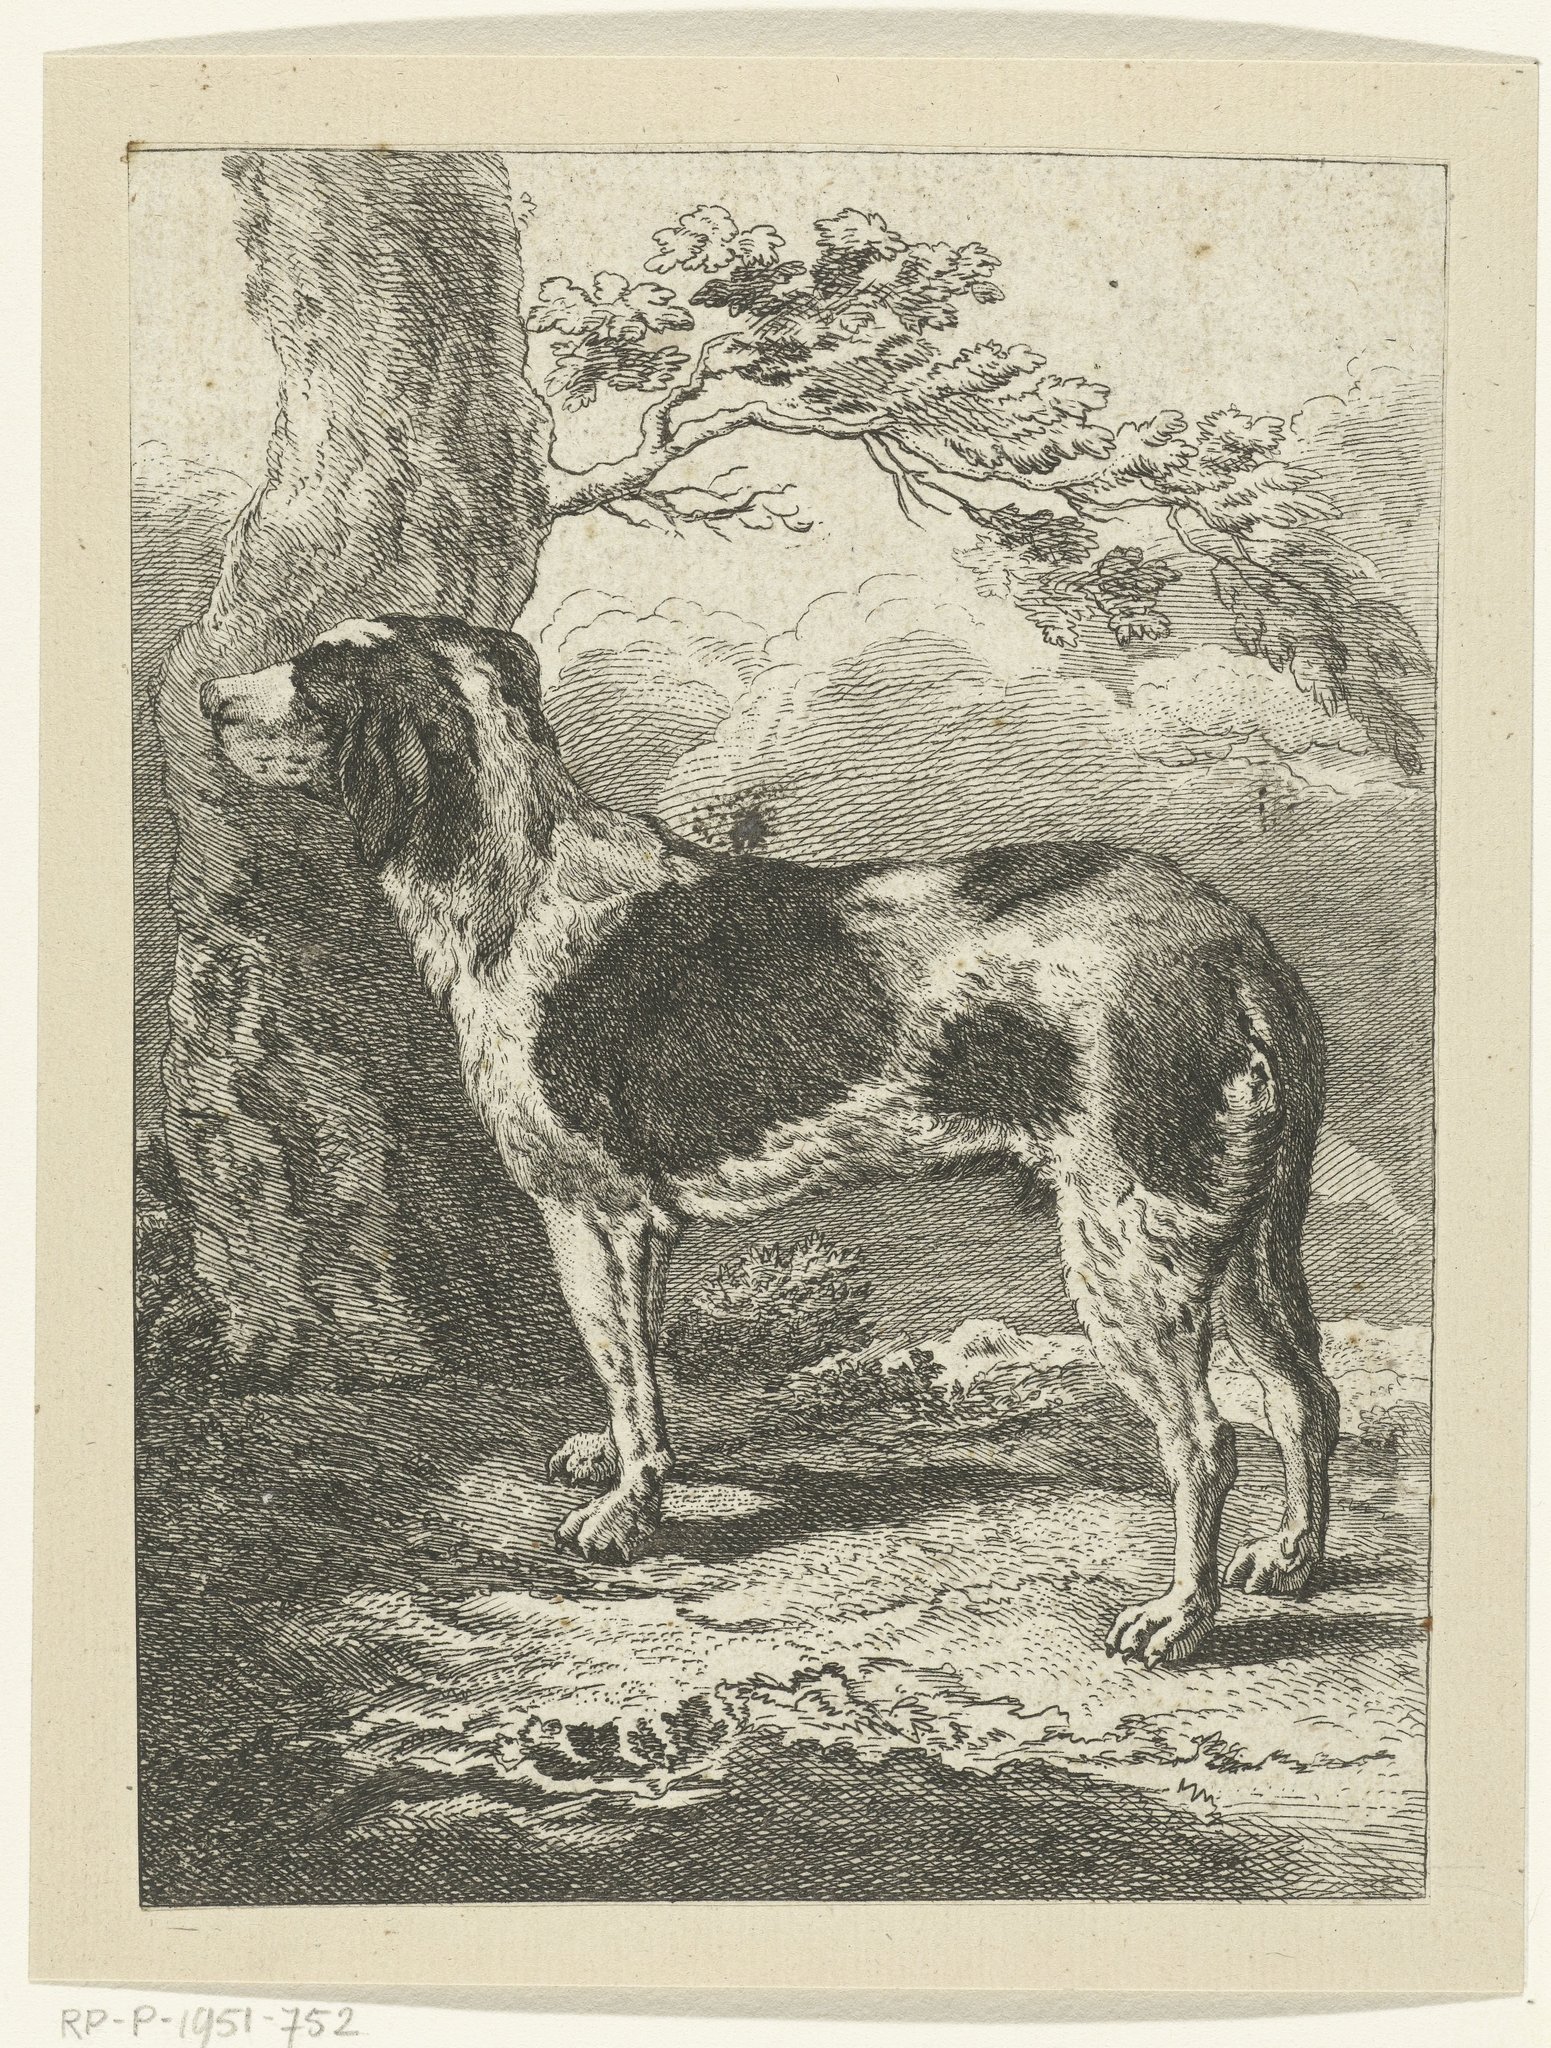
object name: print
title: Staande hond bij boom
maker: pieter barbiers (iv)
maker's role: painter, print maker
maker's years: 1798-1848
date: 1808-1848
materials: paper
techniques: etching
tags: dog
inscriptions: collector's mark: Lugt 2228